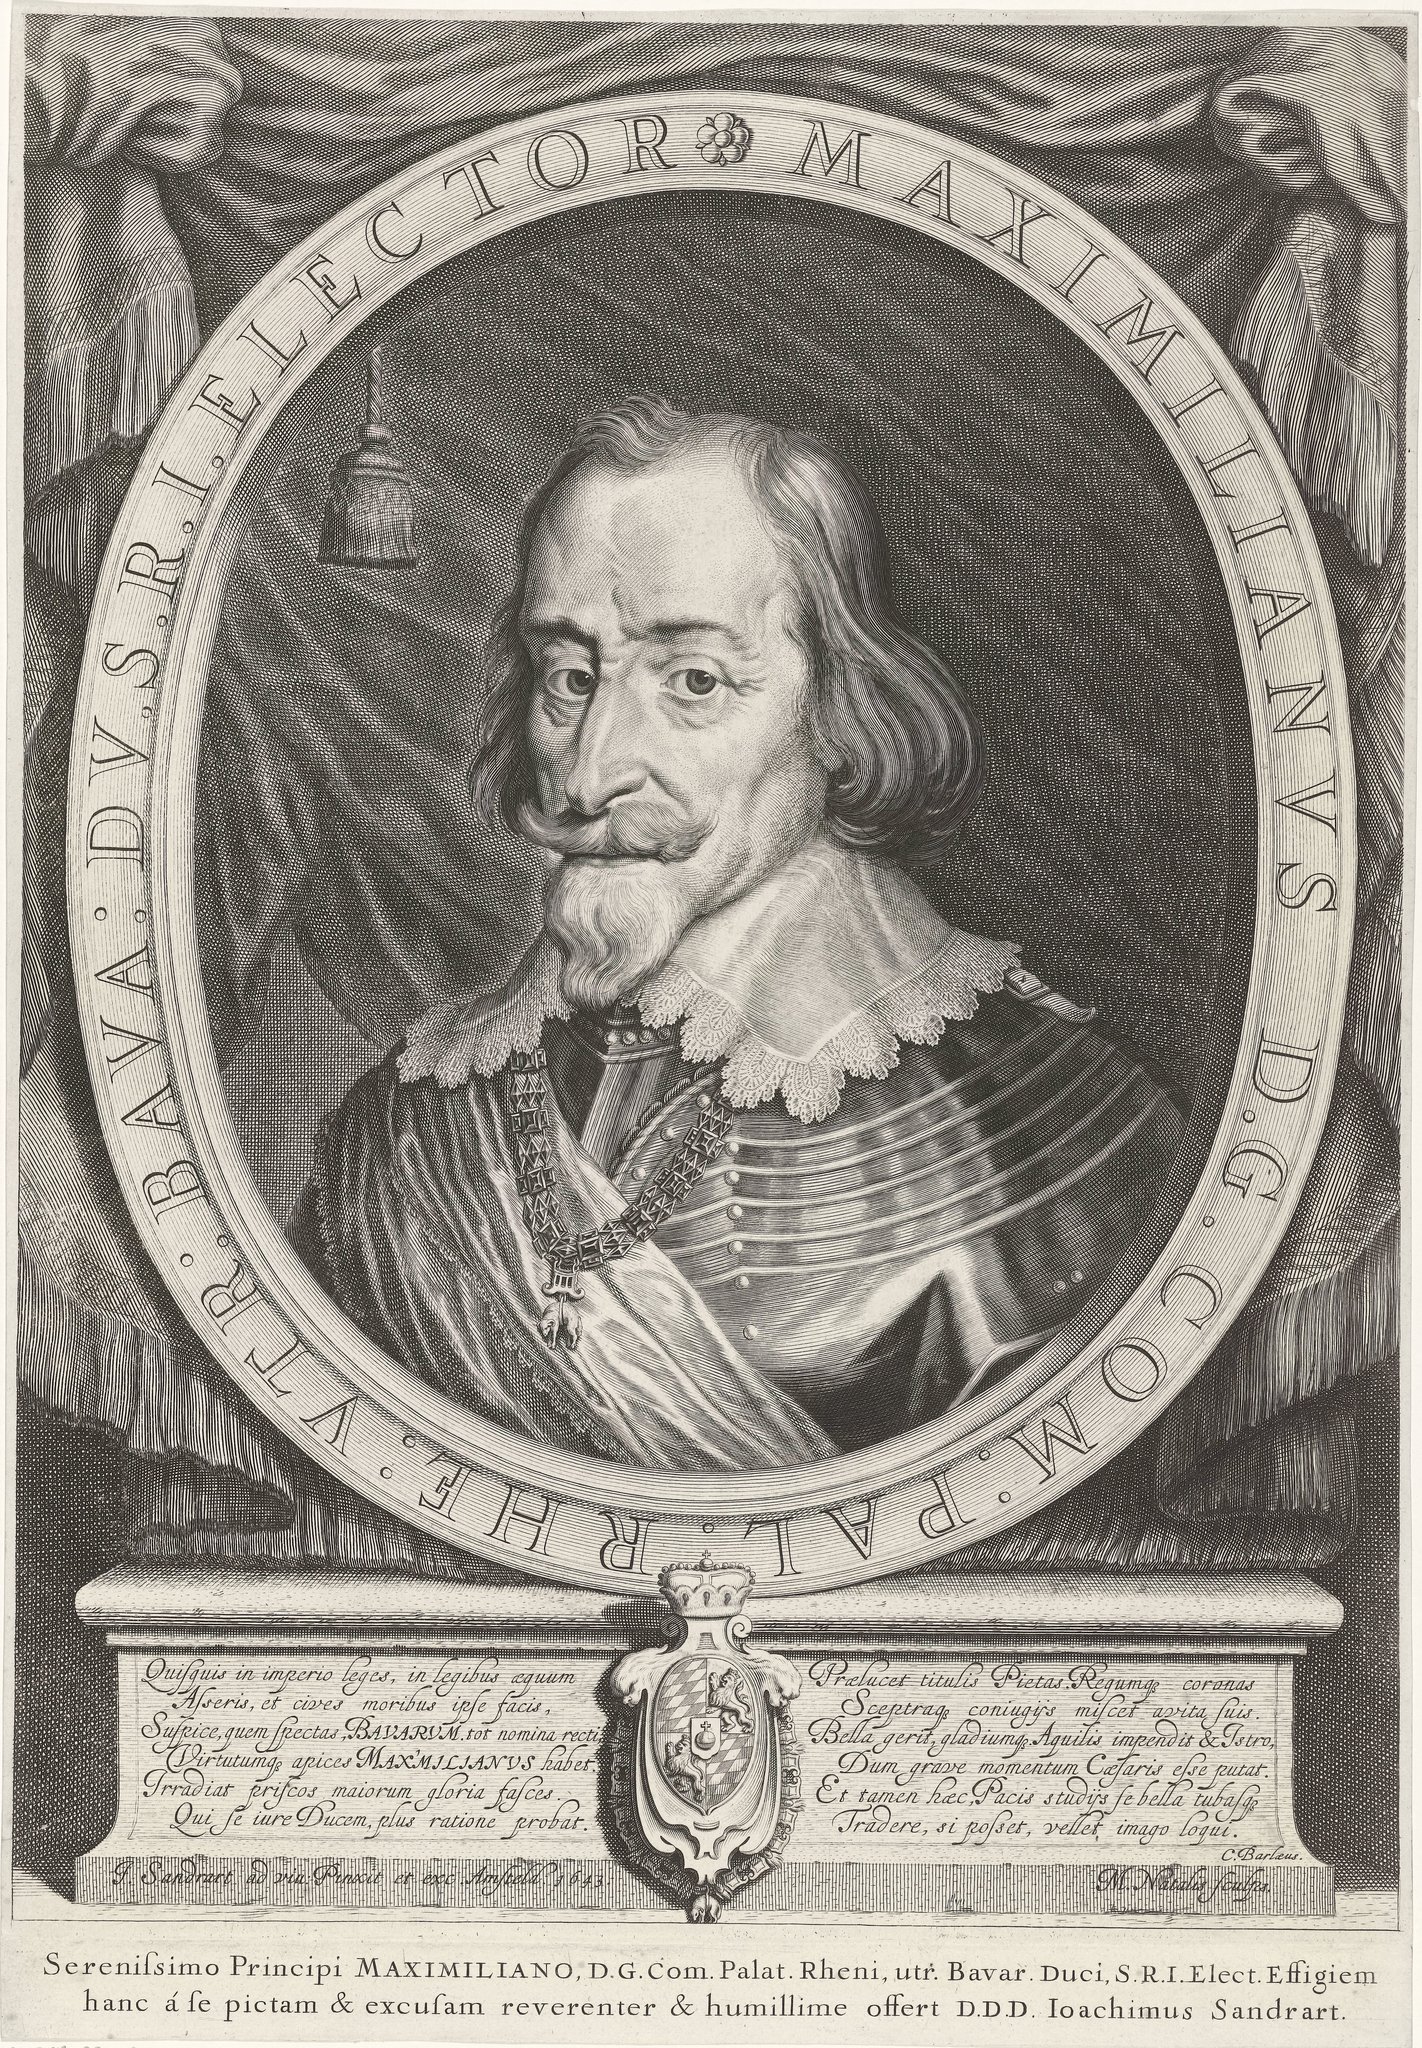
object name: print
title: Portret van Maximiliaan I van Beieren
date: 1643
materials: paper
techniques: engraving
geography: amsterdam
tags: maximiliaan i (keurvorst van beieren), knighthood order of the golden fleece - insignia of a knighthood order, e.g.: badge, chain (with name of order), armorial bearing, heraldry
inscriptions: collector's mark: Lugt 240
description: Portret van Maximiliaan I van Beieren, gekleed in harnas en met sjerp. Op zijn borst hangt de ketting van de Orde van het Gulden Vlies. Buste naar links in ovaal met randschrift. In het midden, onder het portret, zijn wapen en twee zesregelige verzen in het Latijn. Onderaan in de marge een tweeregelige tekst in het Latijn in boekdruk.